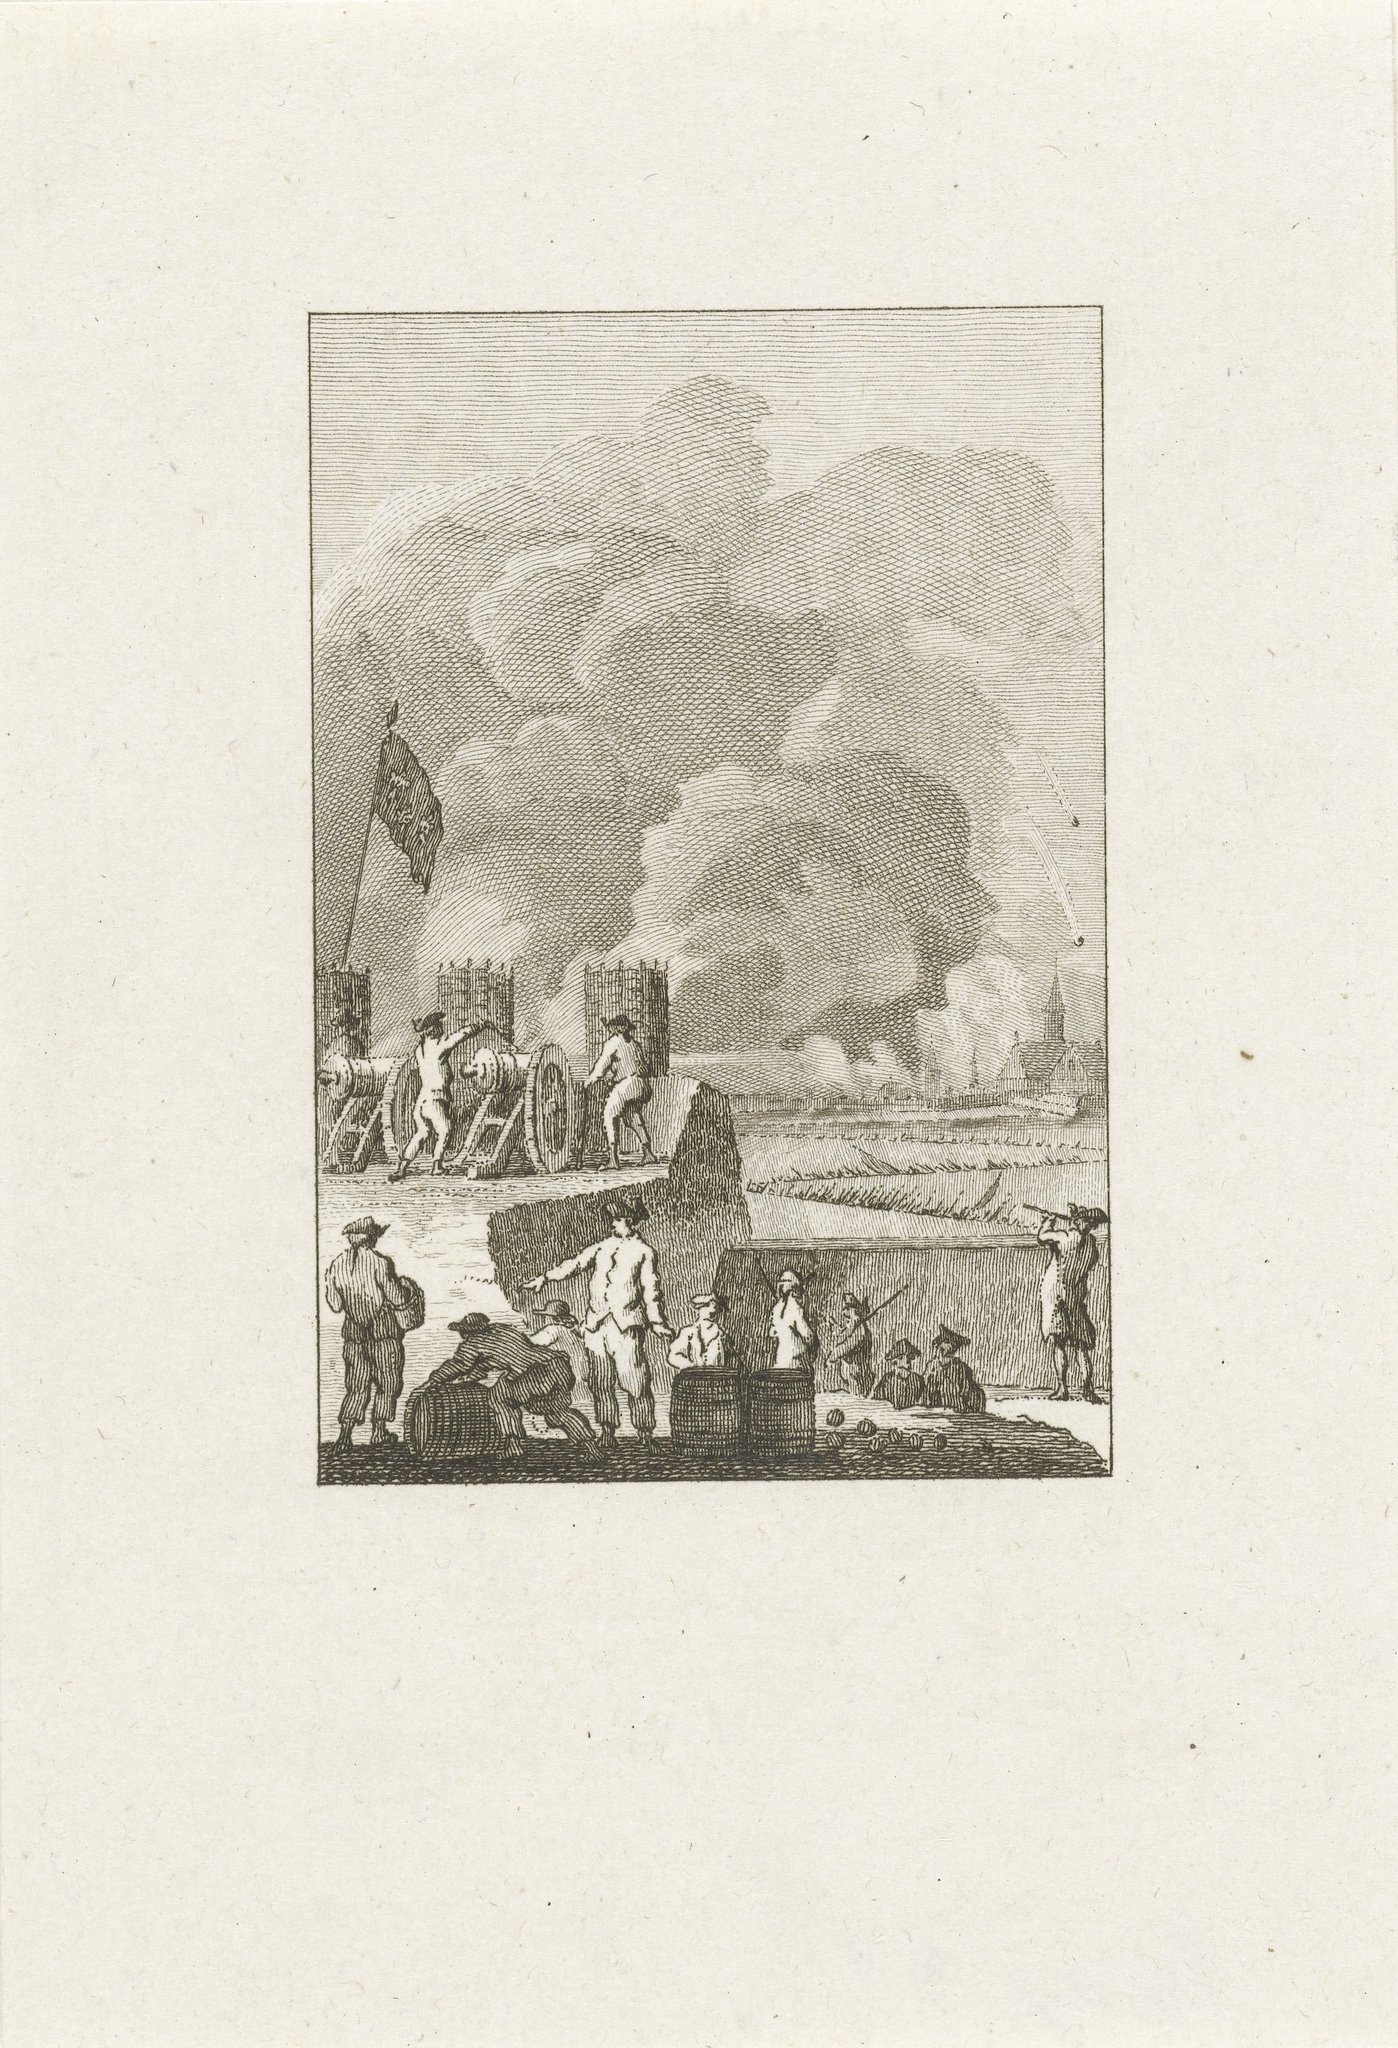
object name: history print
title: Beleg van Bergen op Zoom, 1747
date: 1780-1795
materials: paper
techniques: etching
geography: northern netherlands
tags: siege, position war, bergen op zoom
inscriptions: collector's mark: Lugt 2228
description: Gebruikt als illustratie in: J. Fokke, Geschiedenissen der Vereenigde Nederlanden voor de vaderlandsche jeugd, Johannes Allart, Amsterdam 1783-1795, 25 delen, dl. 11, pl. 3.